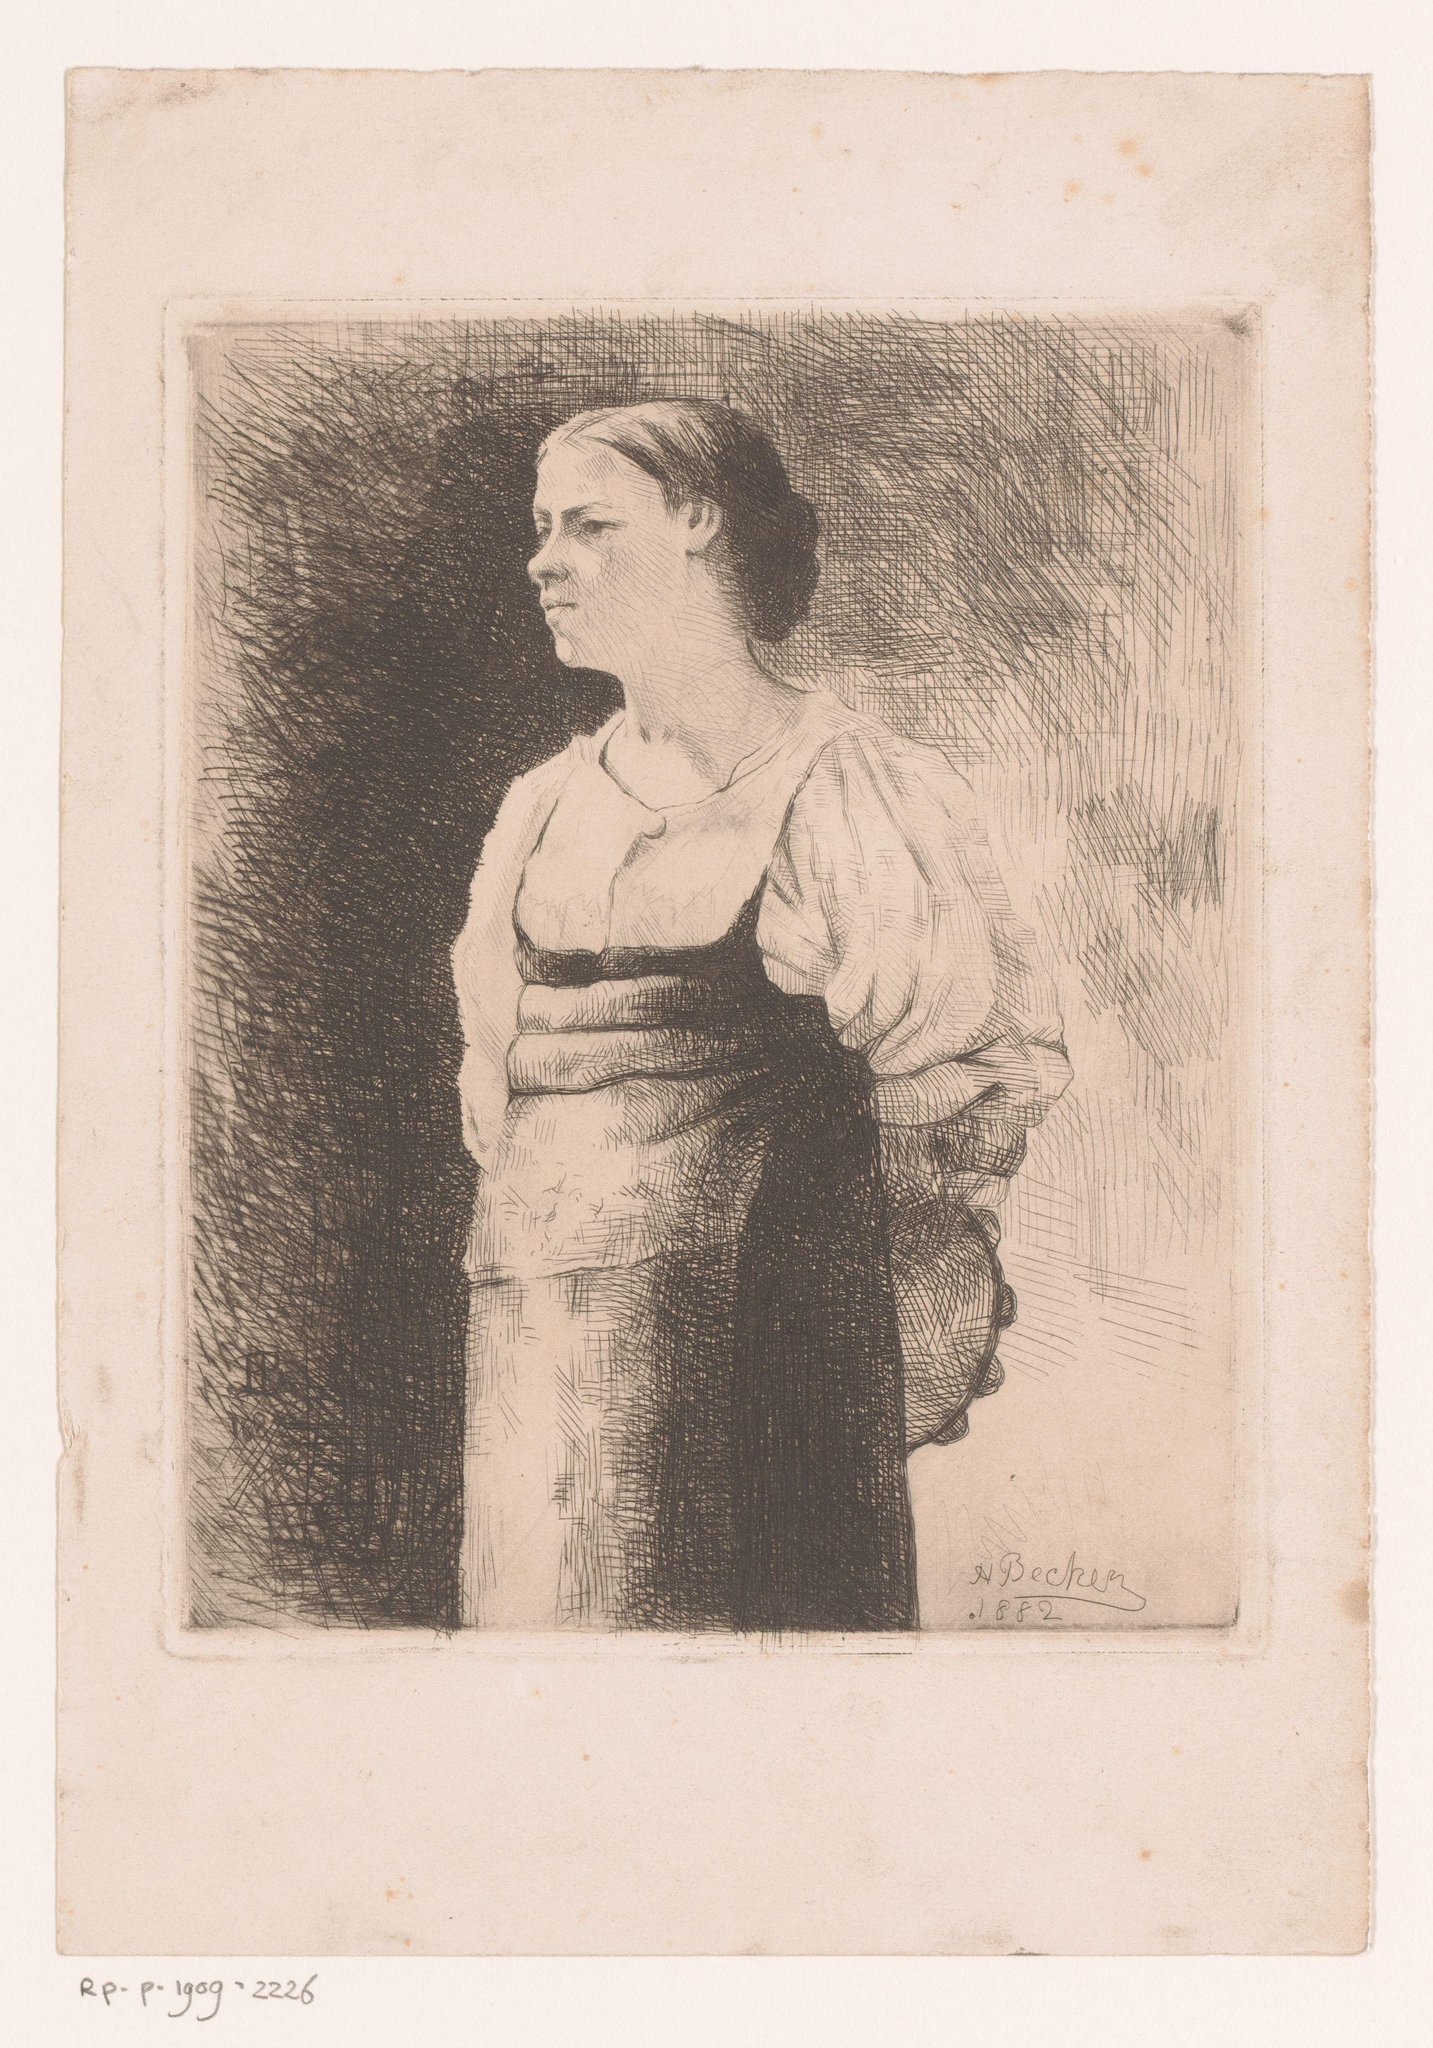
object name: print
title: Jonge vrouw met tamboerijn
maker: h. becker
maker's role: print maker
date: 1882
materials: paper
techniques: etching, intaglio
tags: tambourine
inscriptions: collector's mark: Lugt 2228